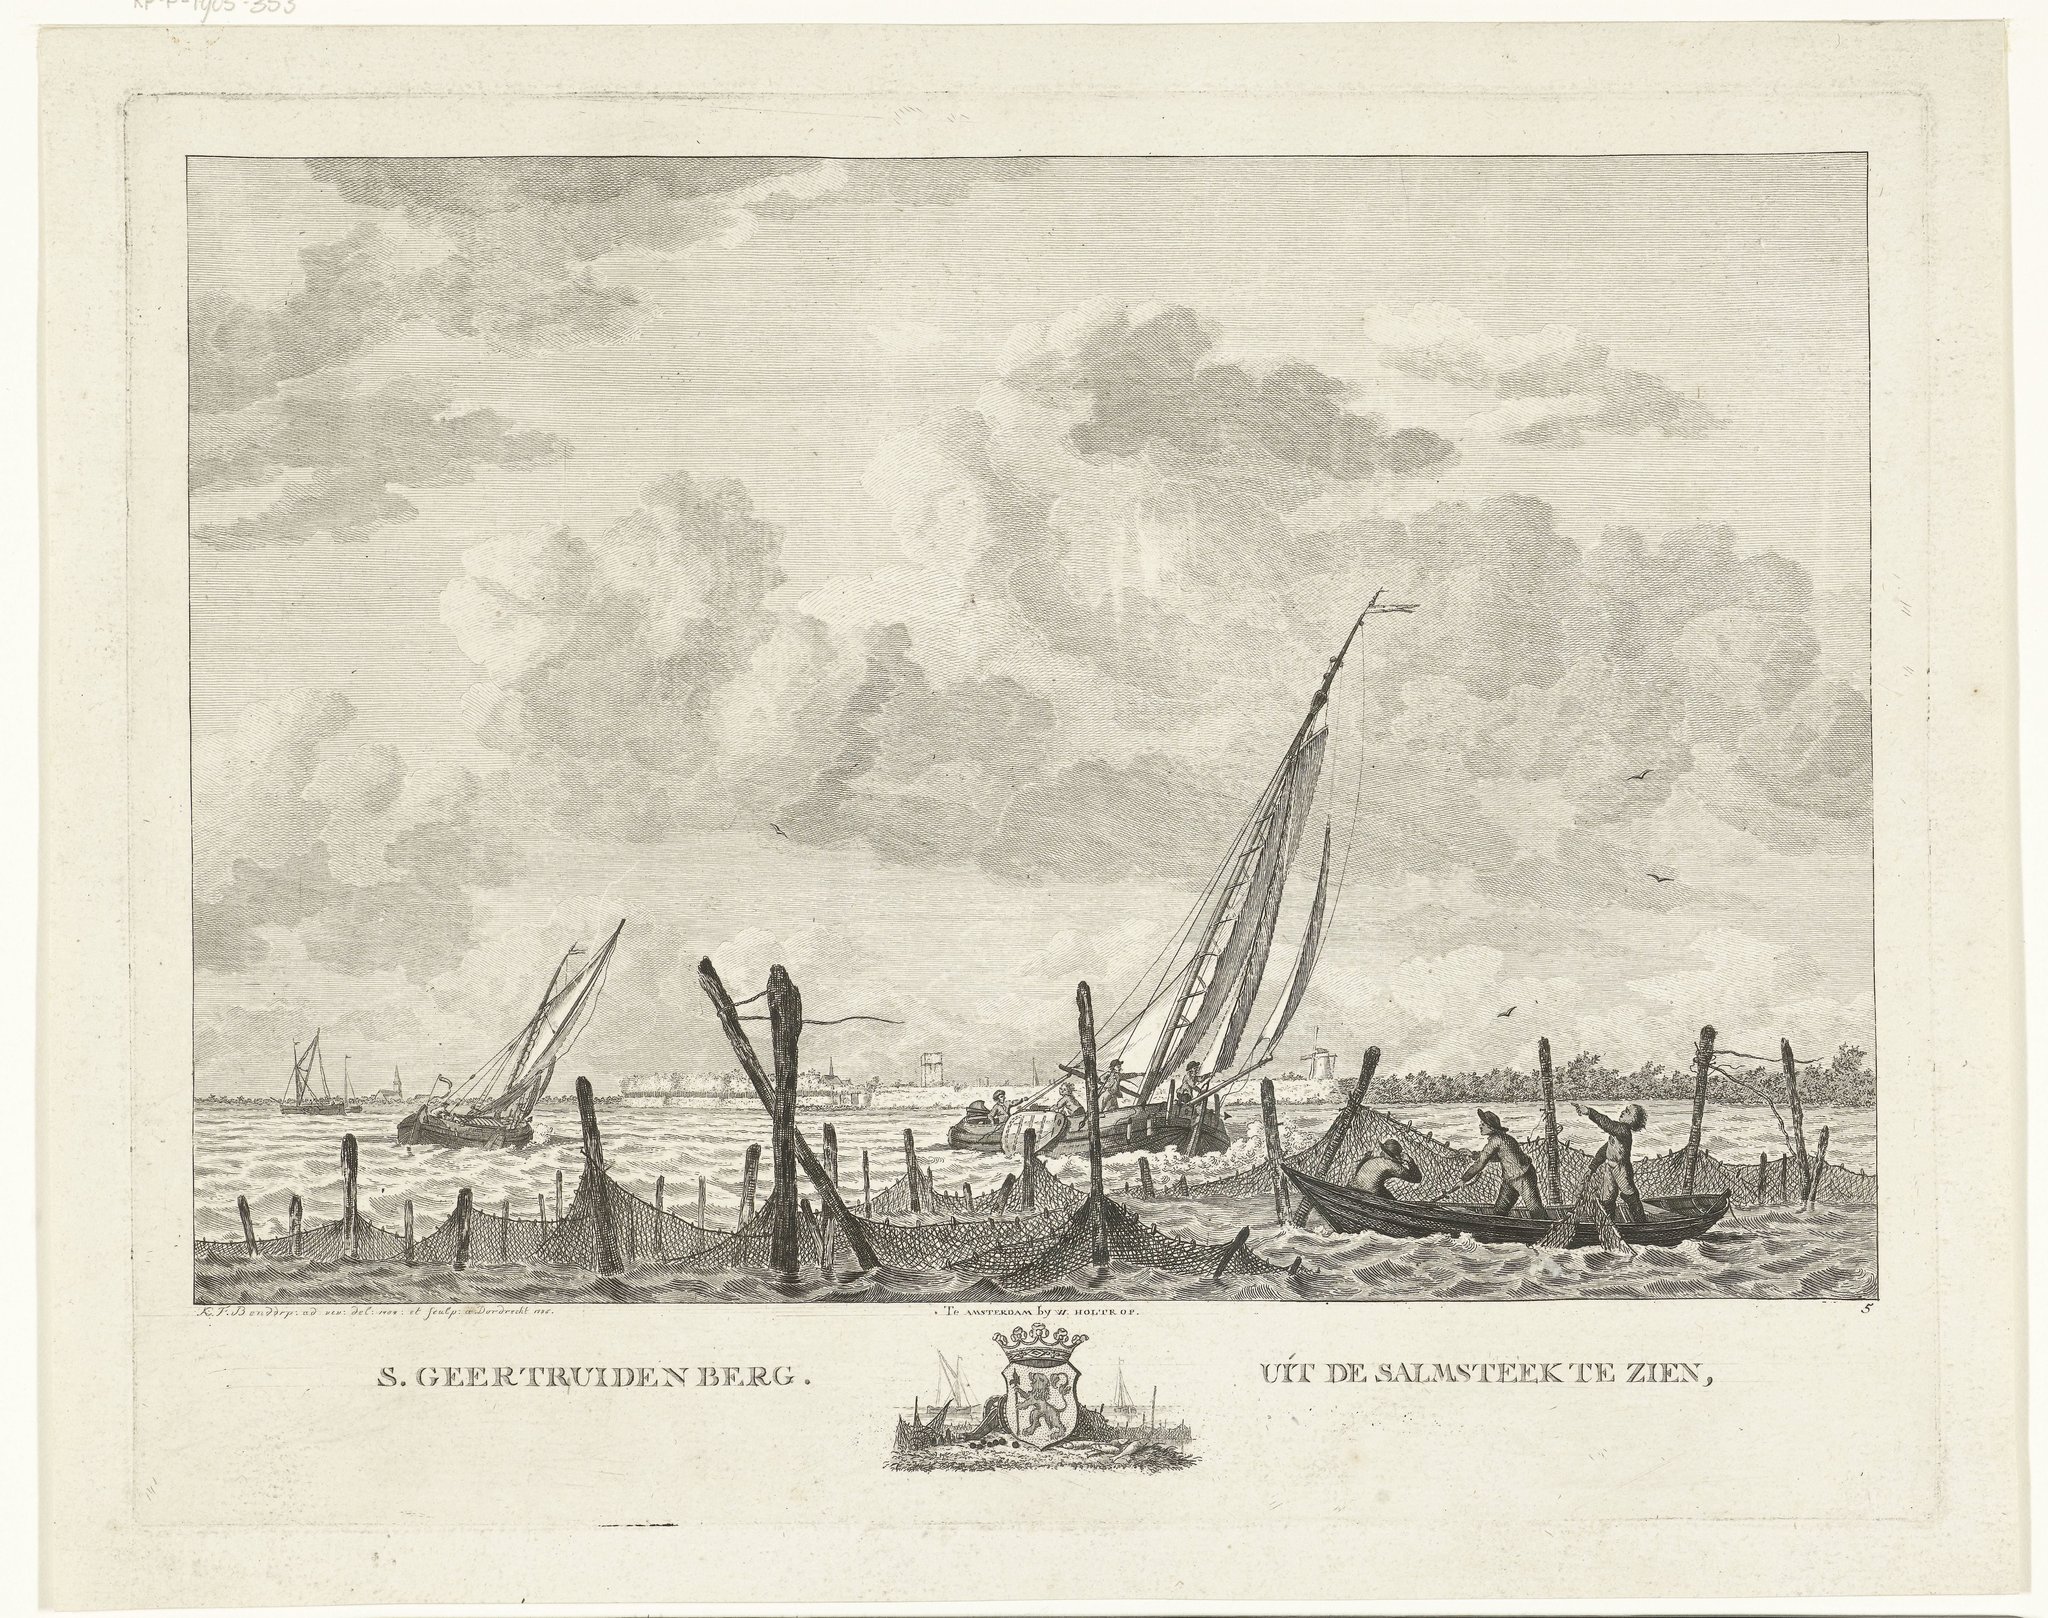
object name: print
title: S. Geertruidenberg. uit de Salmsteek te zien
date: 1786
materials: paper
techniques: etching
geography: amsterdam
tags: prospect of village, silhouette of village, sea (seascape), sea and coastal fishery, geertruidenberg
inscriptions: date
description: Gezicht op het Hollands Diep ter hoogte van Geertruidenberg. Op de voorgrond halen zalmvissers op een kleine boot de netten leeg die zij in het water hebben bevestigd aan houten staken.